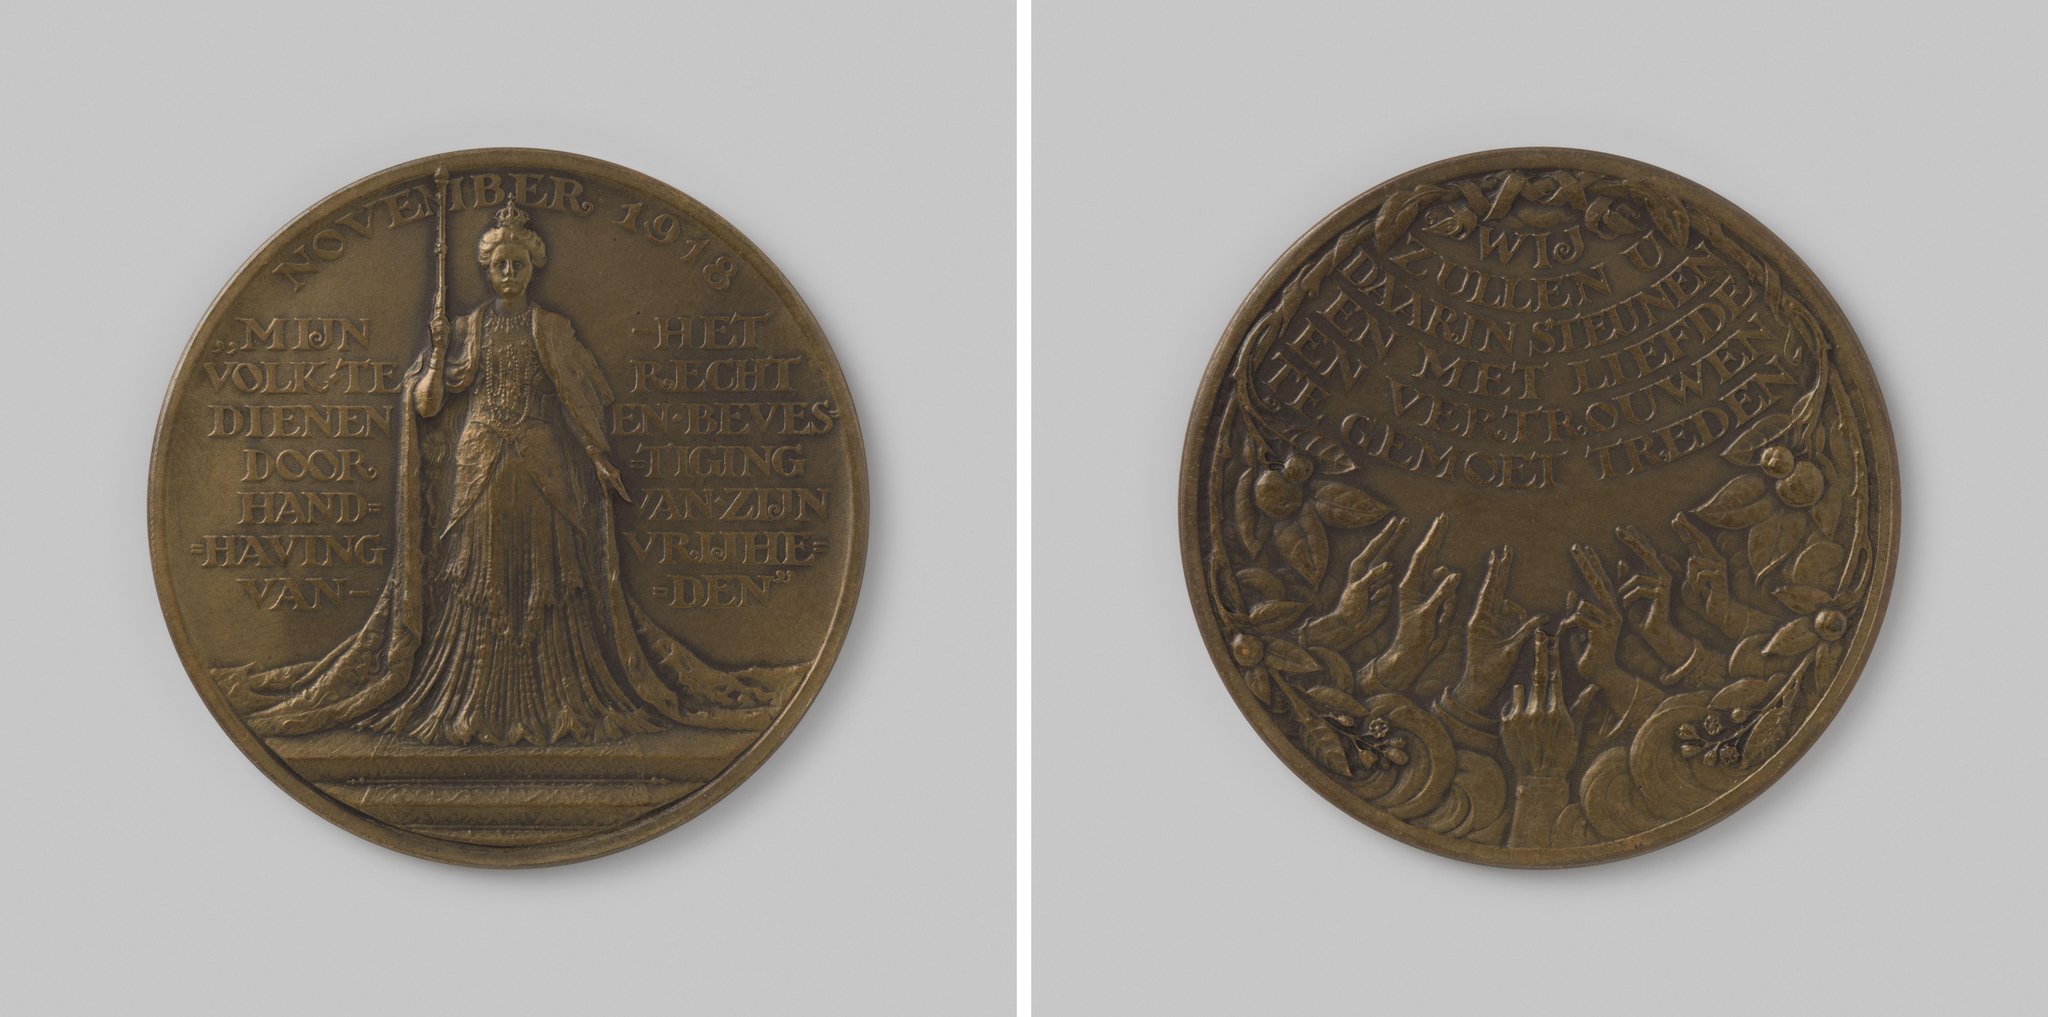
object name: medal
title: Betogingen tegen de revolutie van Troelstra, steun aan koningin Wilhelmina, november 1918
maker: johannes cornelis wienecke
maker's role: medailleur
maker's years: 1872-1945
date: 1918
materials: bronze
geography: apeldoorn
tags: the hague, wilhelmina of the netherlands, politician, netherlands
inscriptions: inscription: ‘Wij zullen u daarin steunen en met liefde en vertrouwen te gemoet treden’, inscription: ‘November 1918 / "Mijn volk te dienen door handhaving van // het recht en bevestiging van zijn vrijheden"’